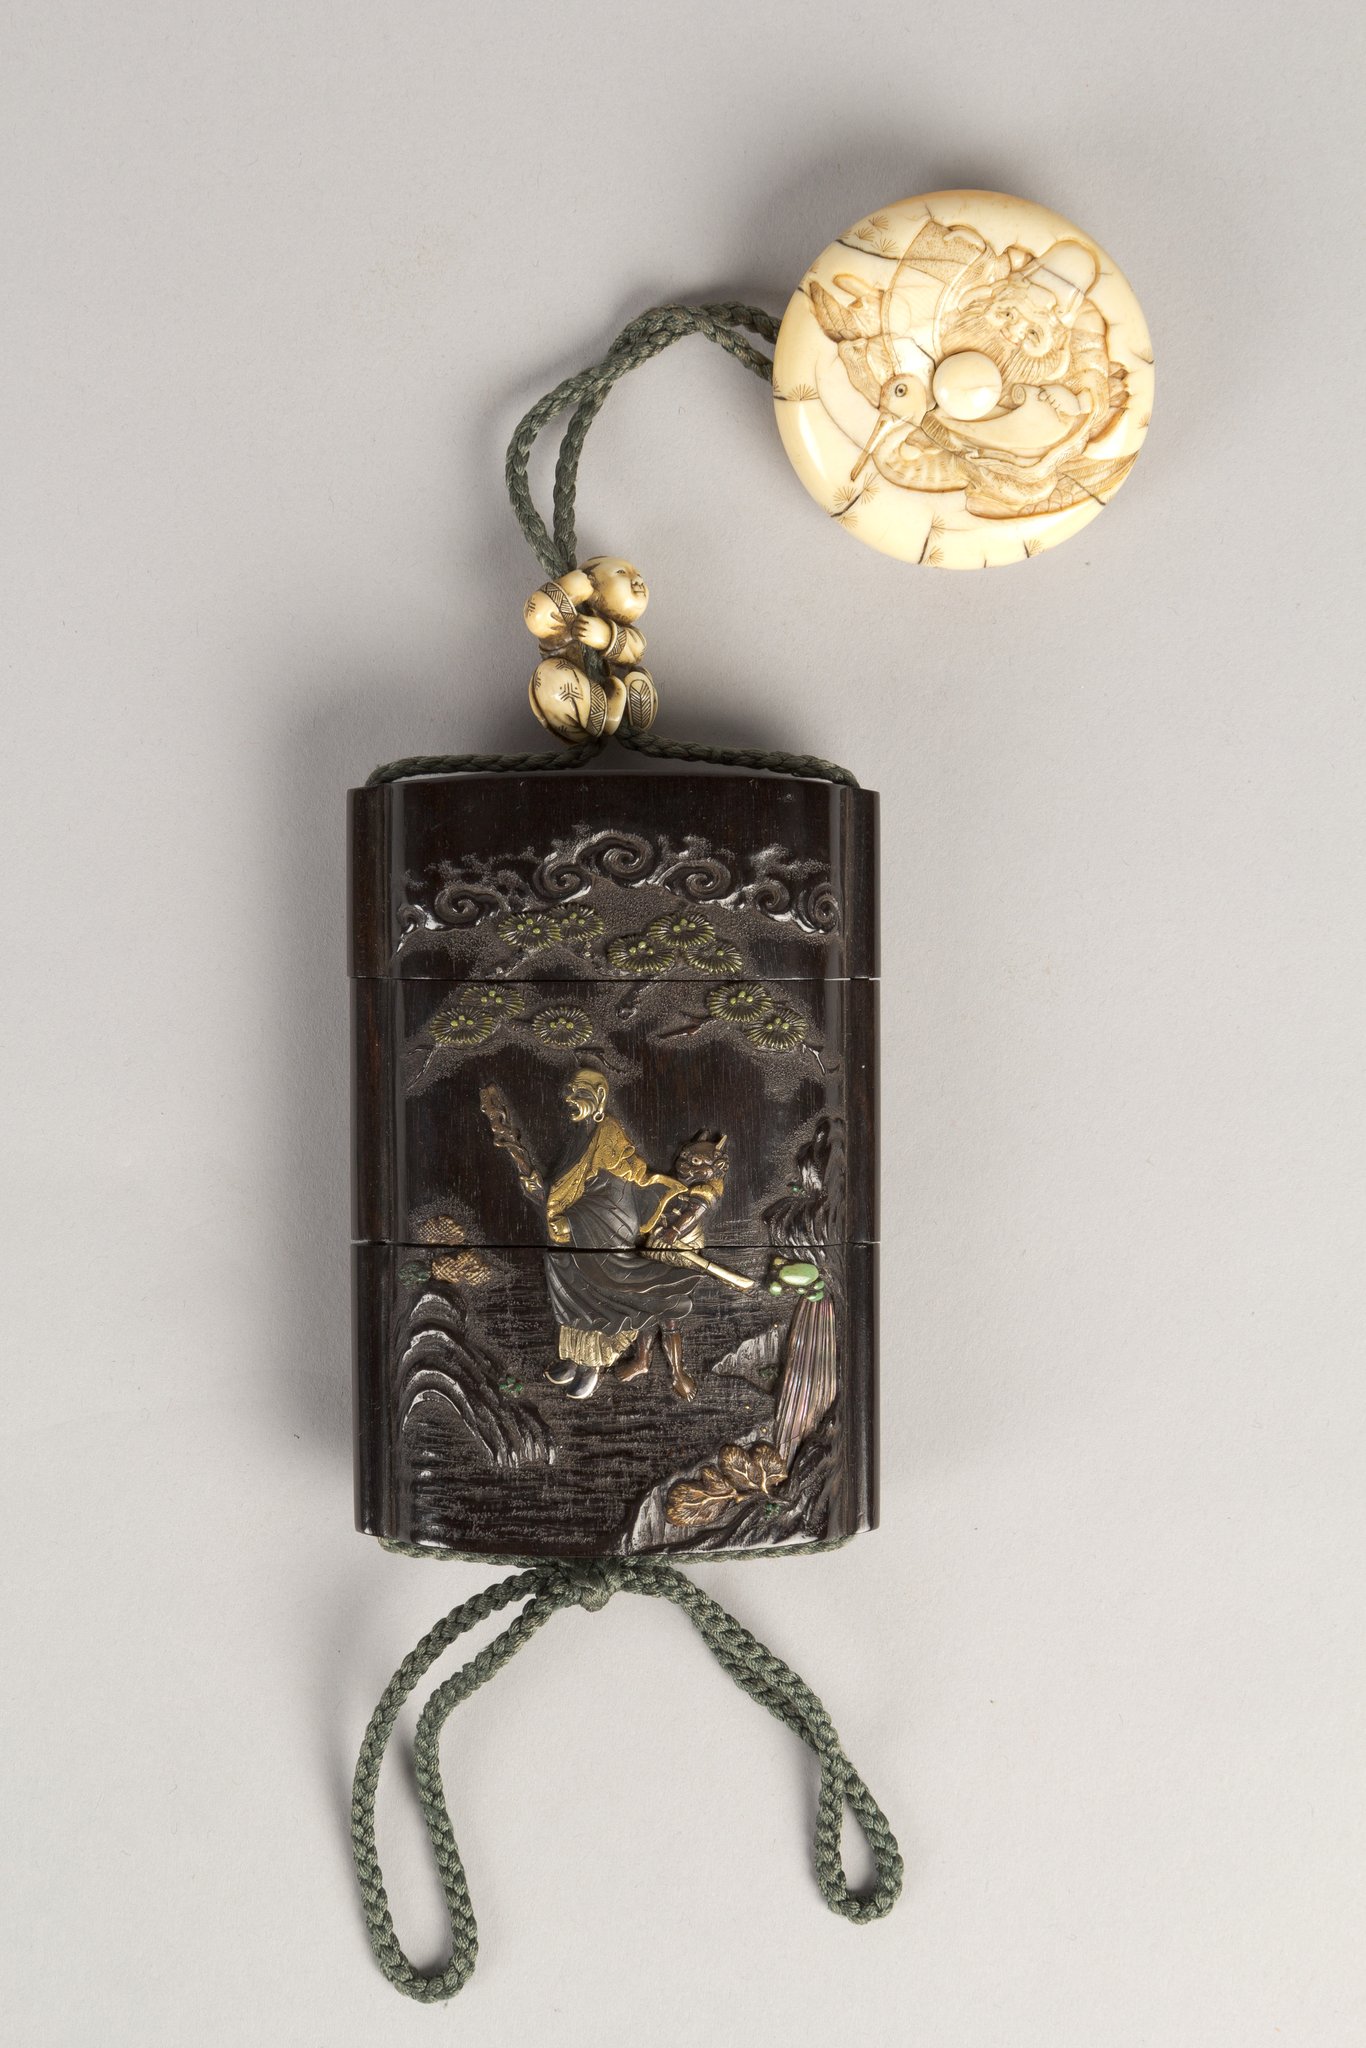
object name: inrō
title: Case (Inrō) with Design of Ōni (Demon) Standing Behind Cloak of Arhat (obverse); Fly Whisk (Hossu) beneath Pine Tree (reverse)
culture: japanese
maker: tokoku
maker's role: artist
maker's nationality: japanese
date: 1801-1900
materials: wood, ivory, metal, fiber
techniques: carving, inlay, relief